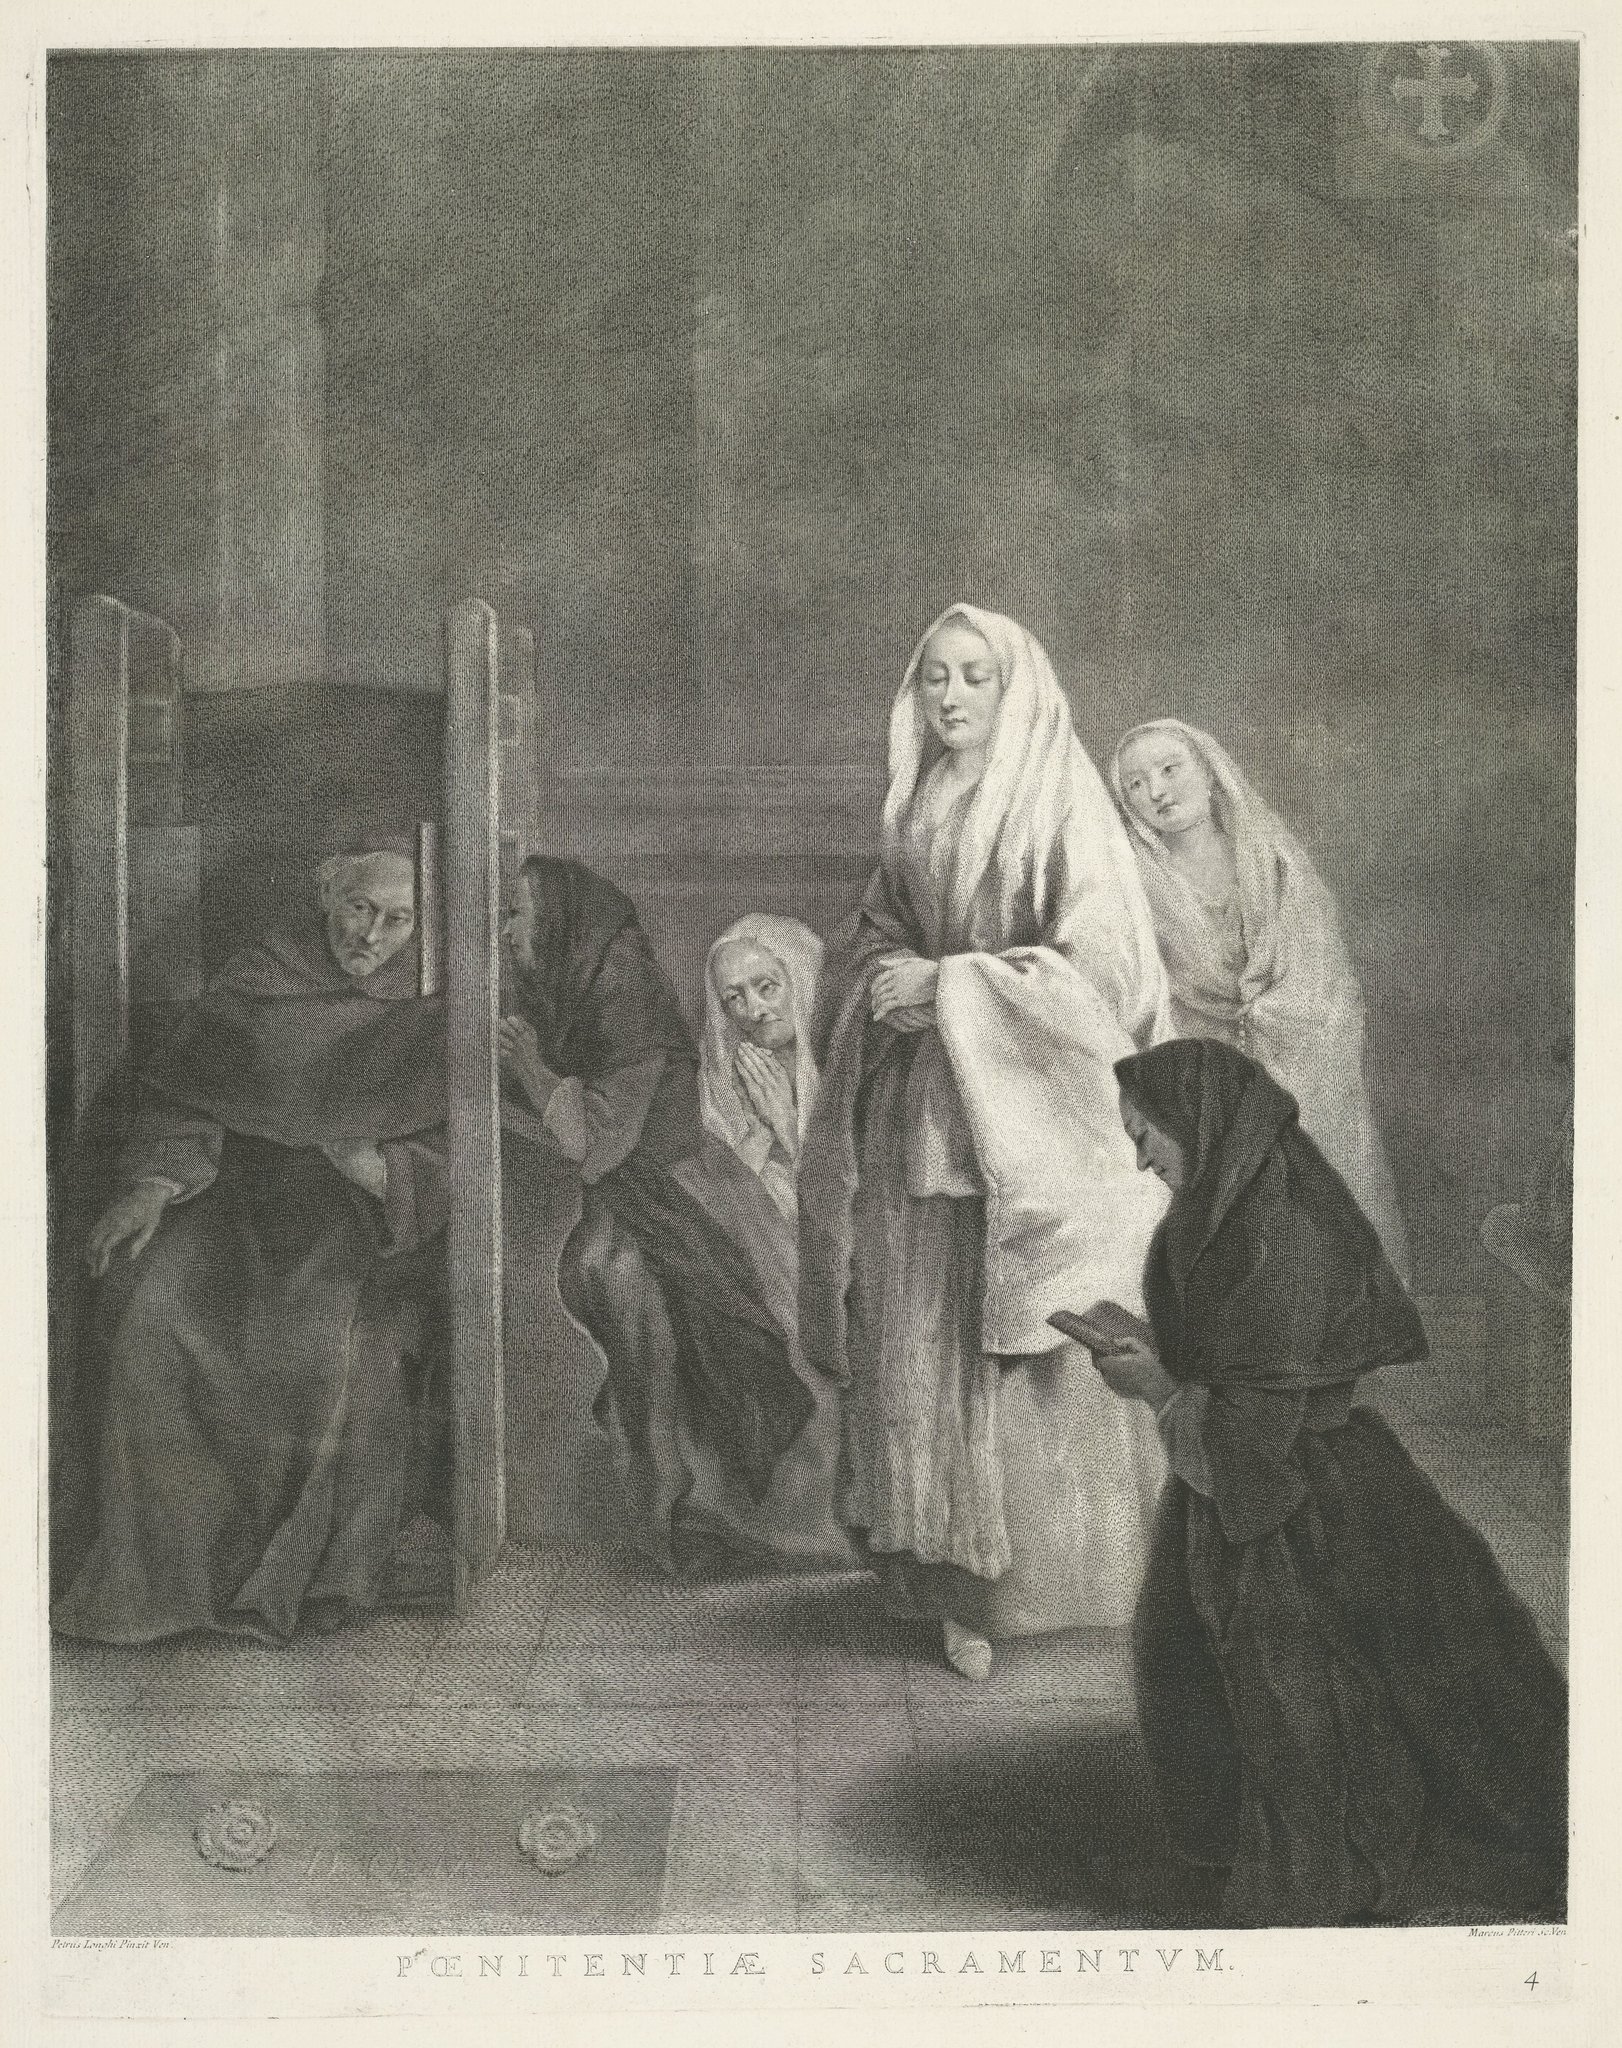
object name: print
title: Poenitentiae Sacramentum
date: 1712-1786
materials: paper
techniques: engraving, etching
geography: venice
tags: the seven sacraments of the roman catholic church, confession; 'confessione sacramentale' (ripa) ~ the third of the seven sacraments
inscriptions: collector's mark: Lugt 240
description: Het sacrament van de biecht. Een rij vrouwen staat in de rij om te biechten bij een geestelijke in een biechtstoel.